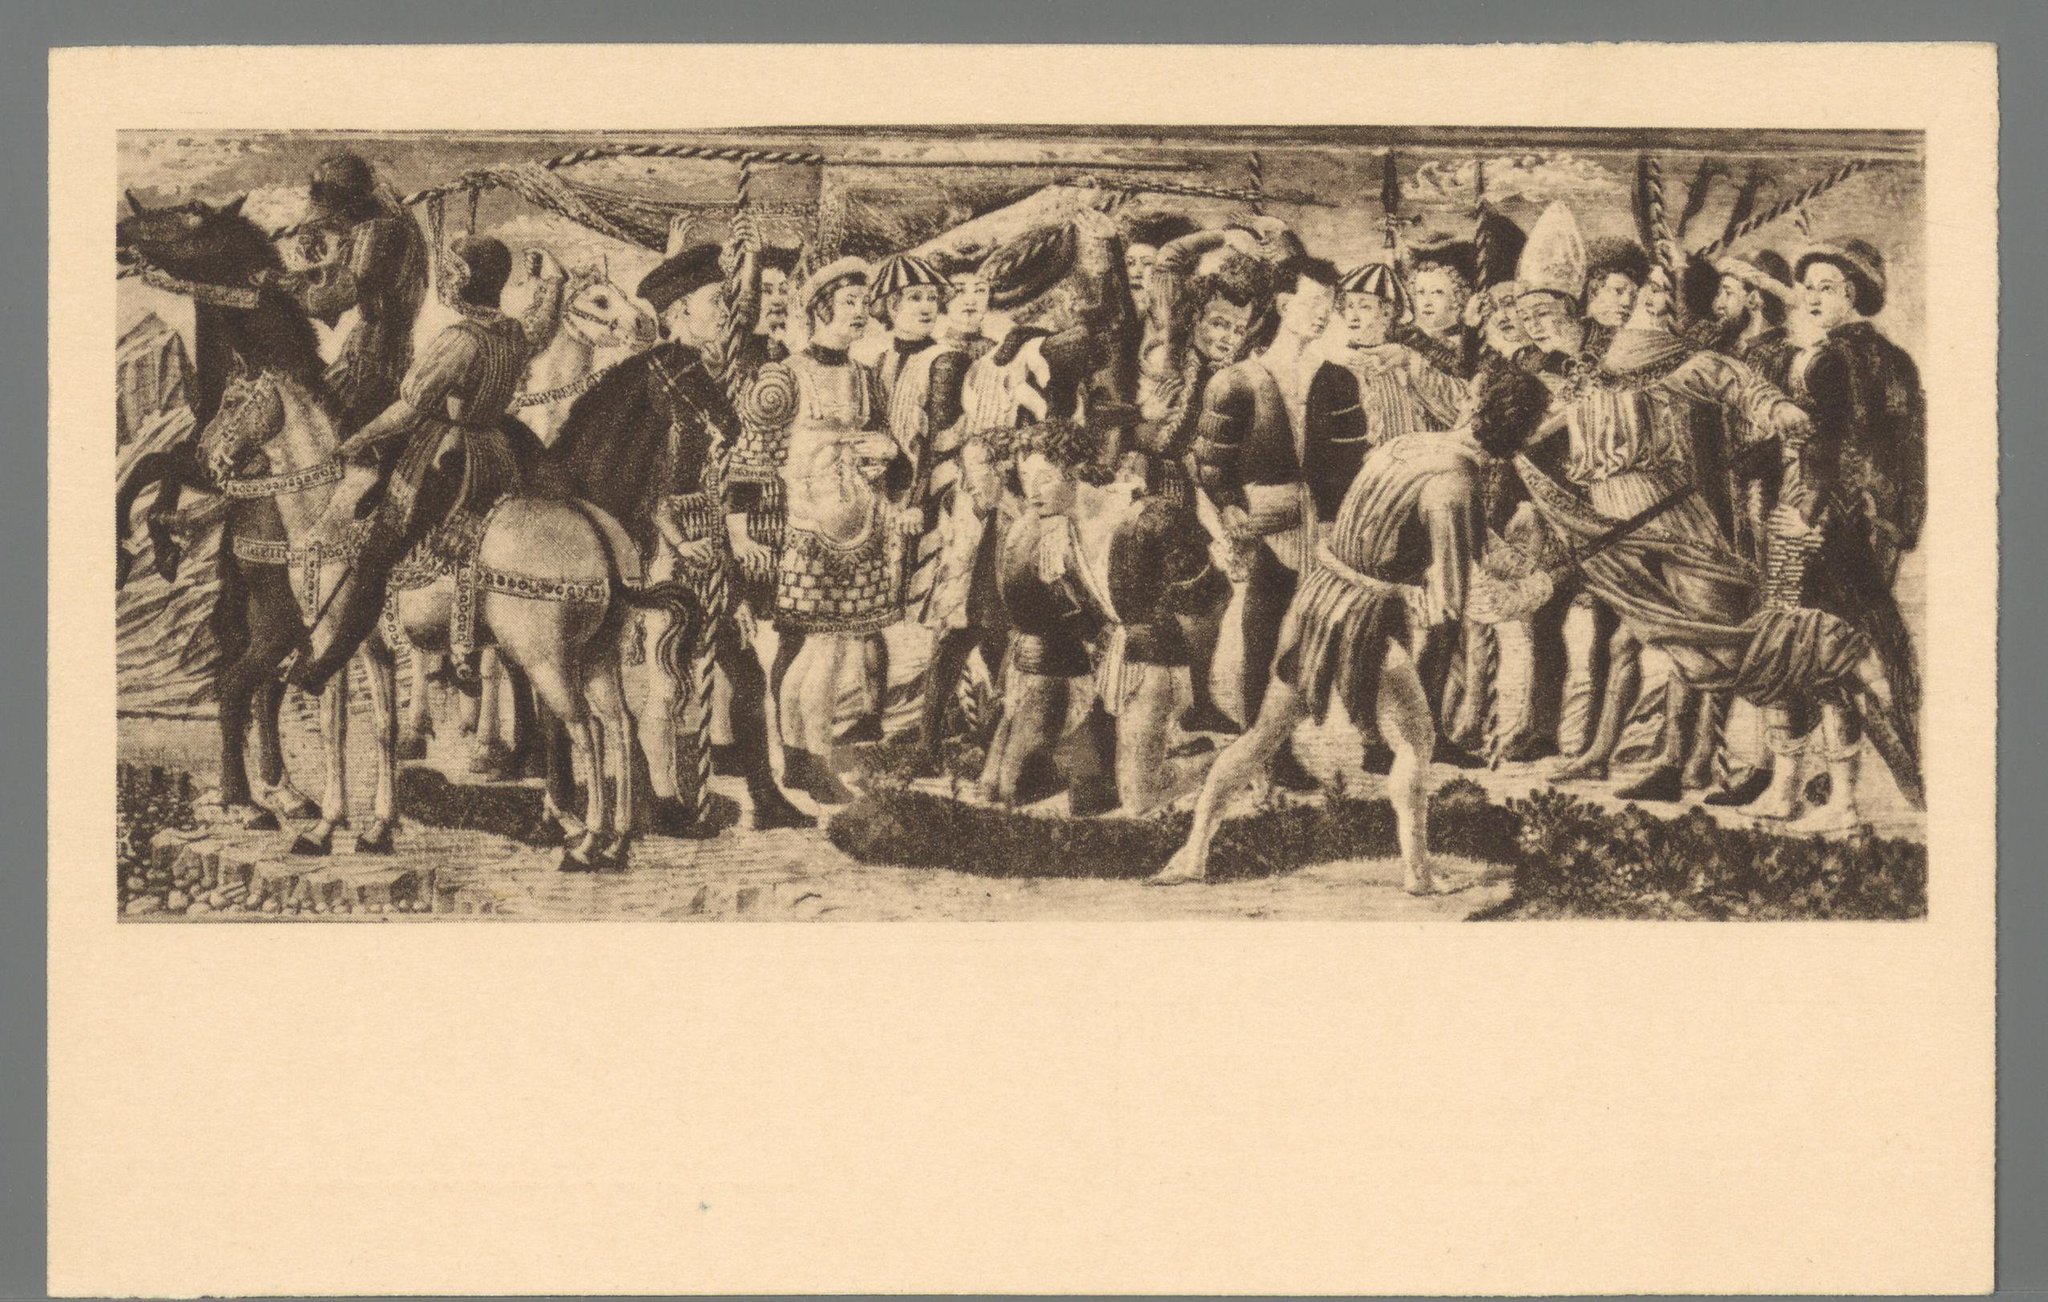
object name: reproduction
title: Francesco Pesellino (c. 1422-1457). De H. Nicolaas redt drie onschuldig veroordeelde oficieren - Florence, Galleria Buonarroti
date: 1928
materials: cardboard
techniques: rotogravure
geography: milan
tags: permanent exhibition, museum, picture, painting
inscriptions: collector's mark: ‘AFE v S’